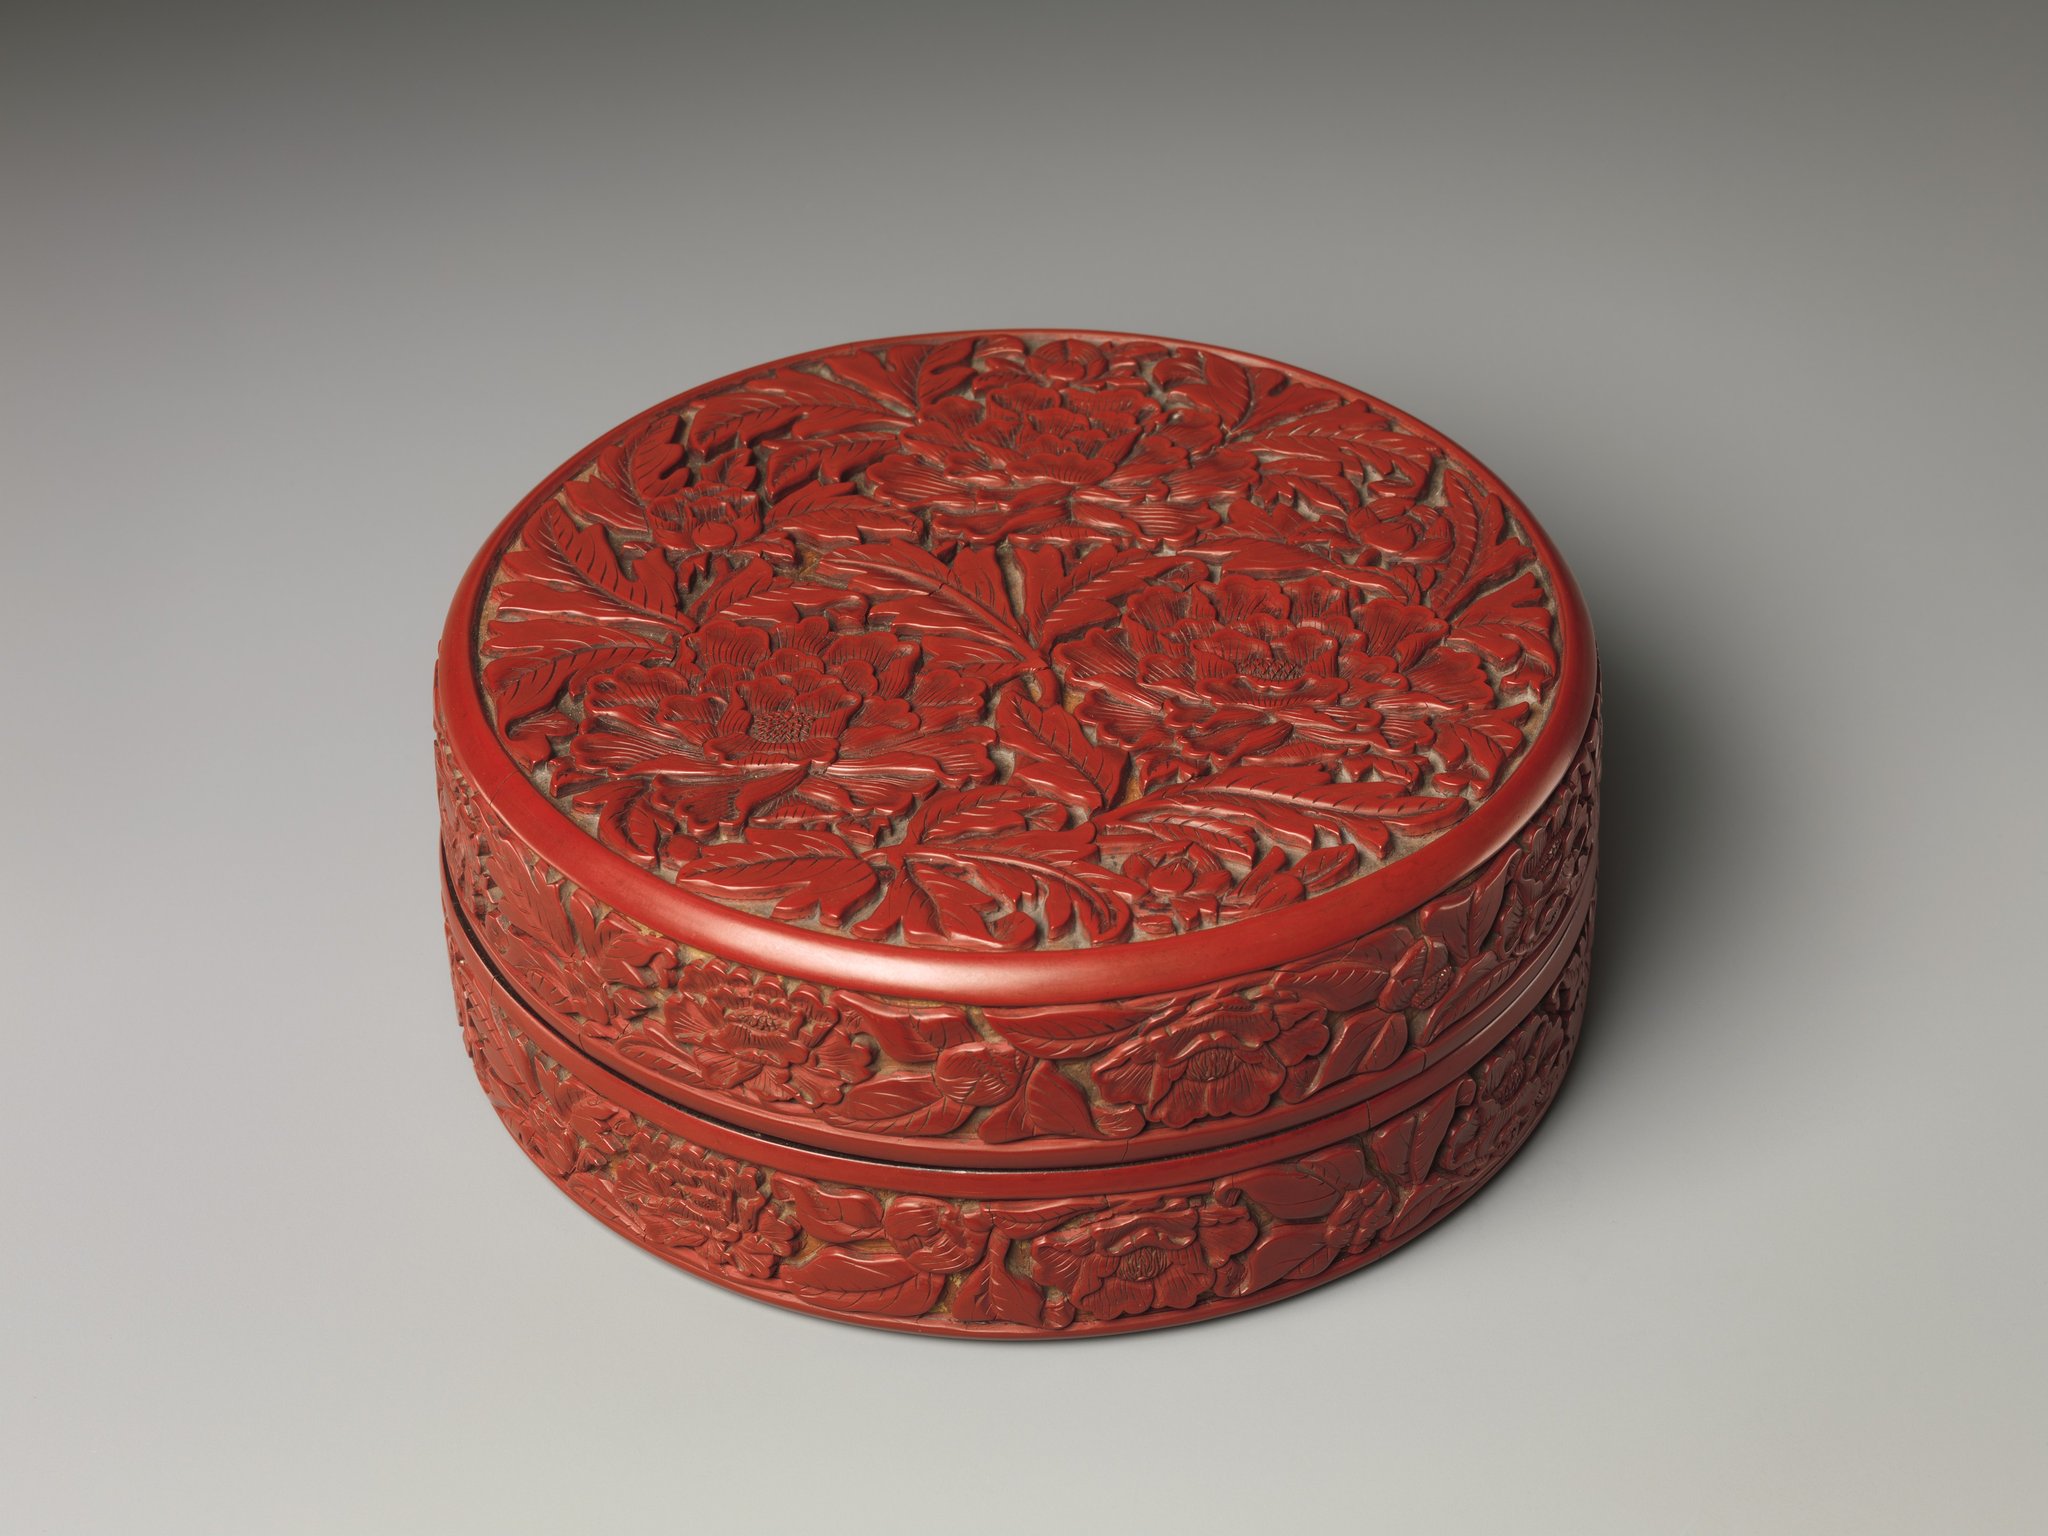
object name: box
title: Box with peonies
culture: chinese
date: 1401-1500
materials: lacquer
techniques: carving